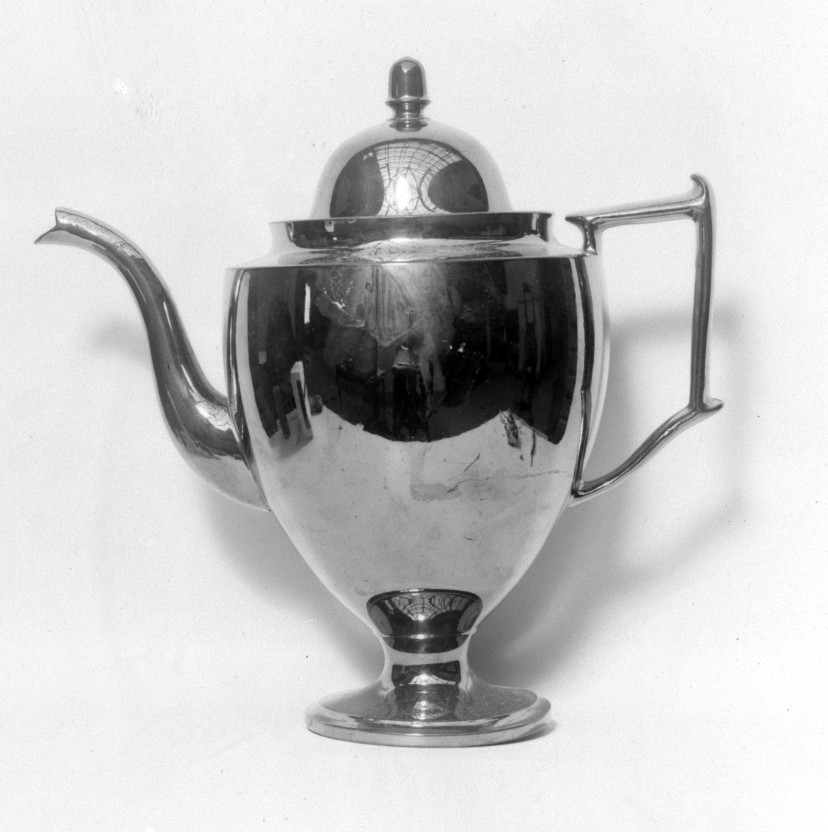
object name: coffeepot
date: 1810-1840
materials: earthenware